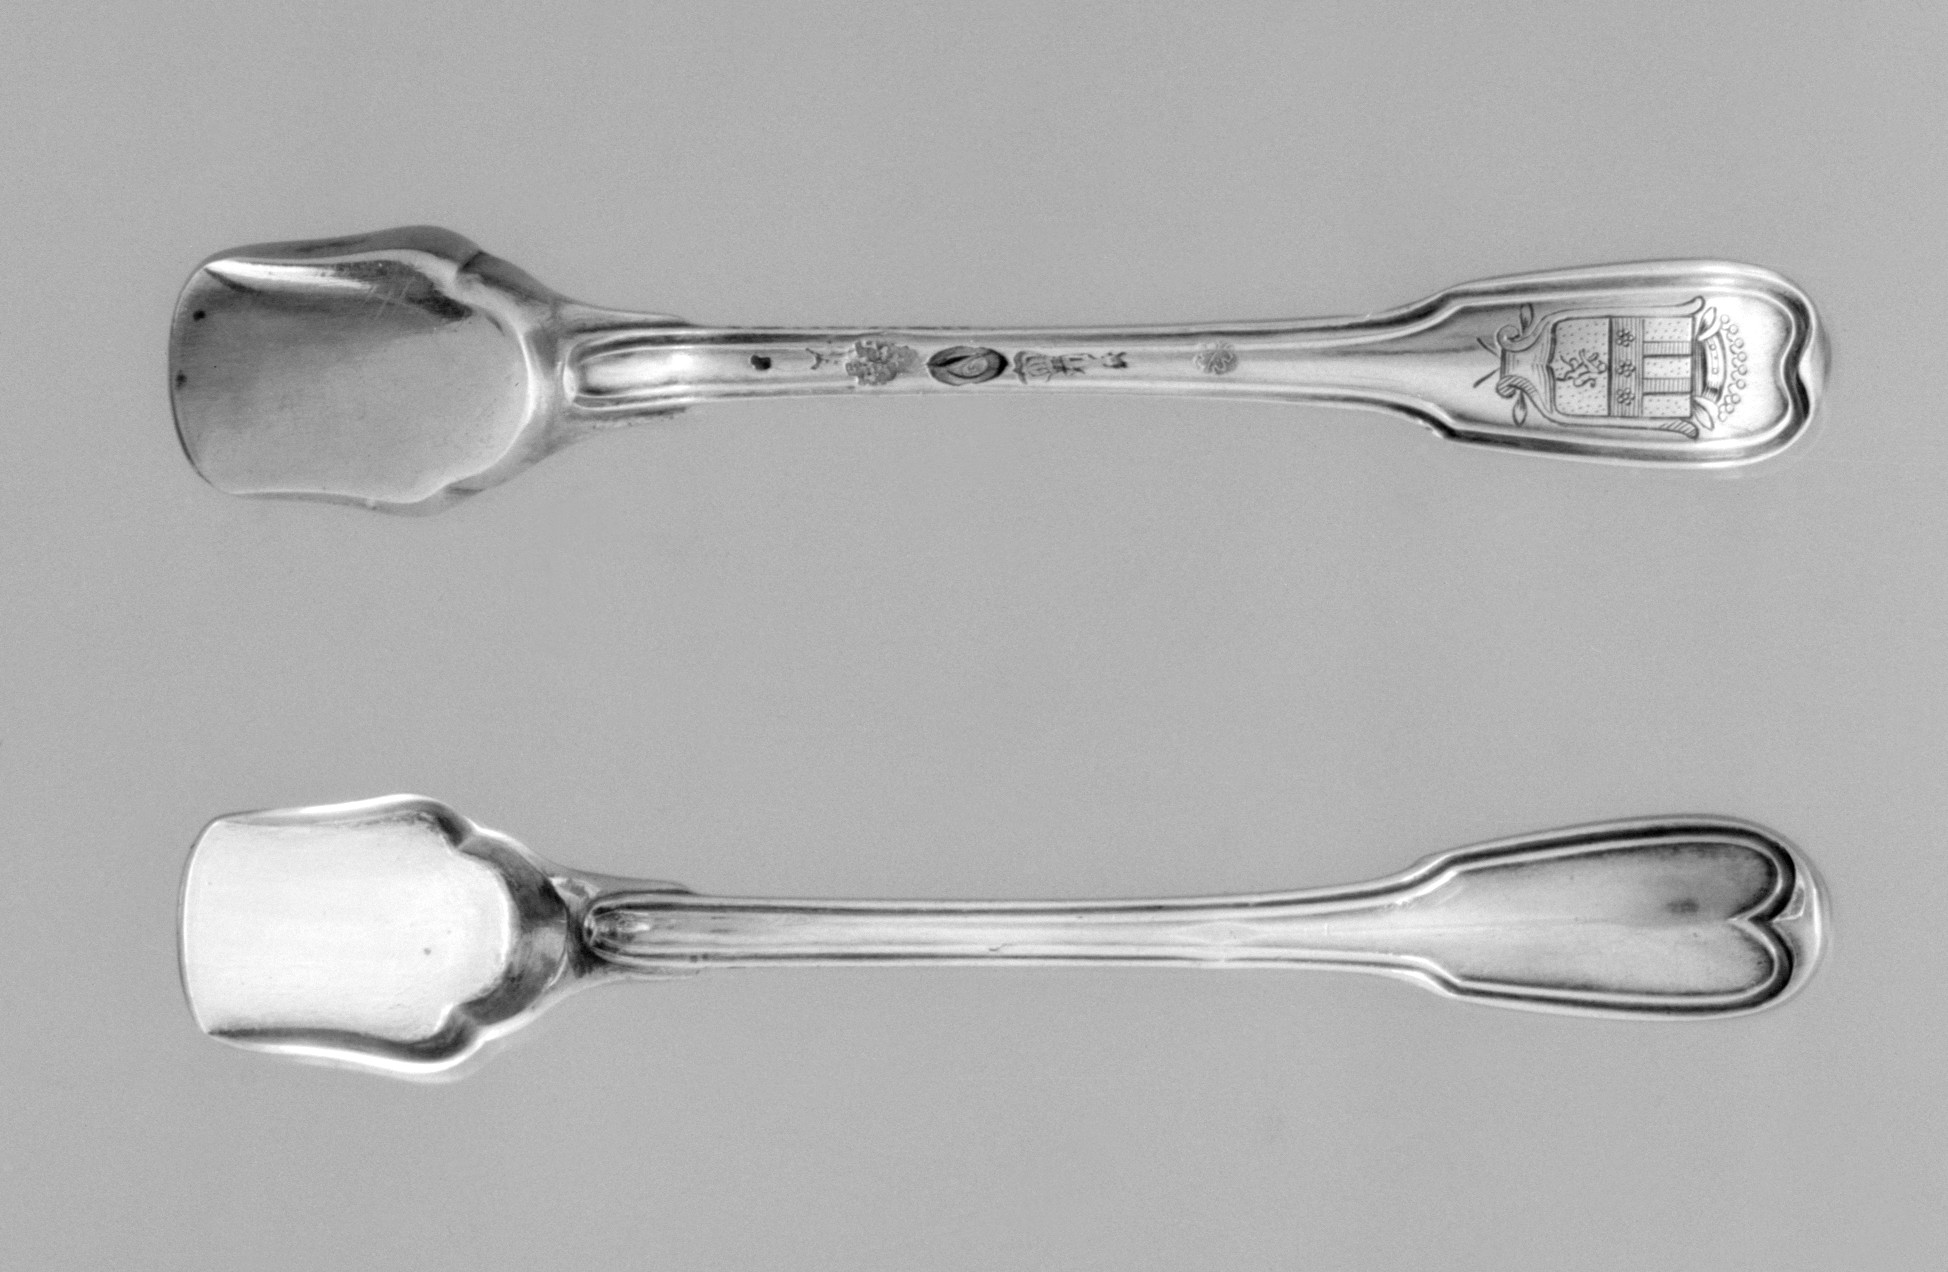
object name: salt spoon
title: Pair of salt spoons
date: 1789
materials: silver